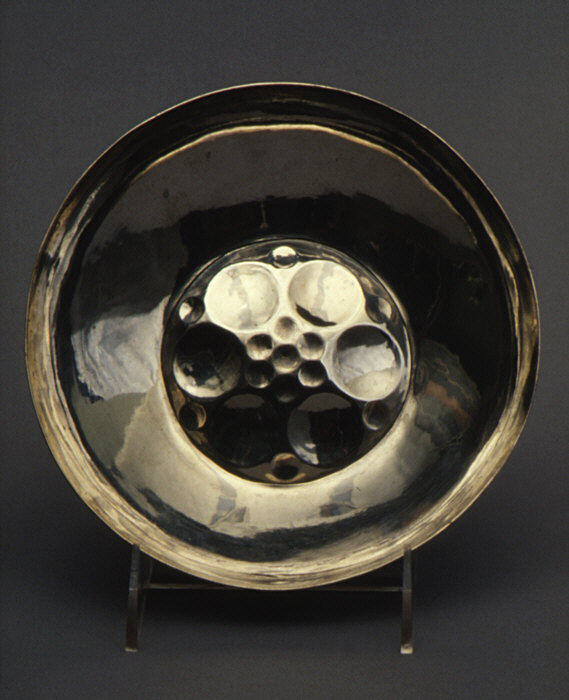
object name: bowl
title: Bowl (one of a pair)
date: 1451-1500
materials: gilt, silver